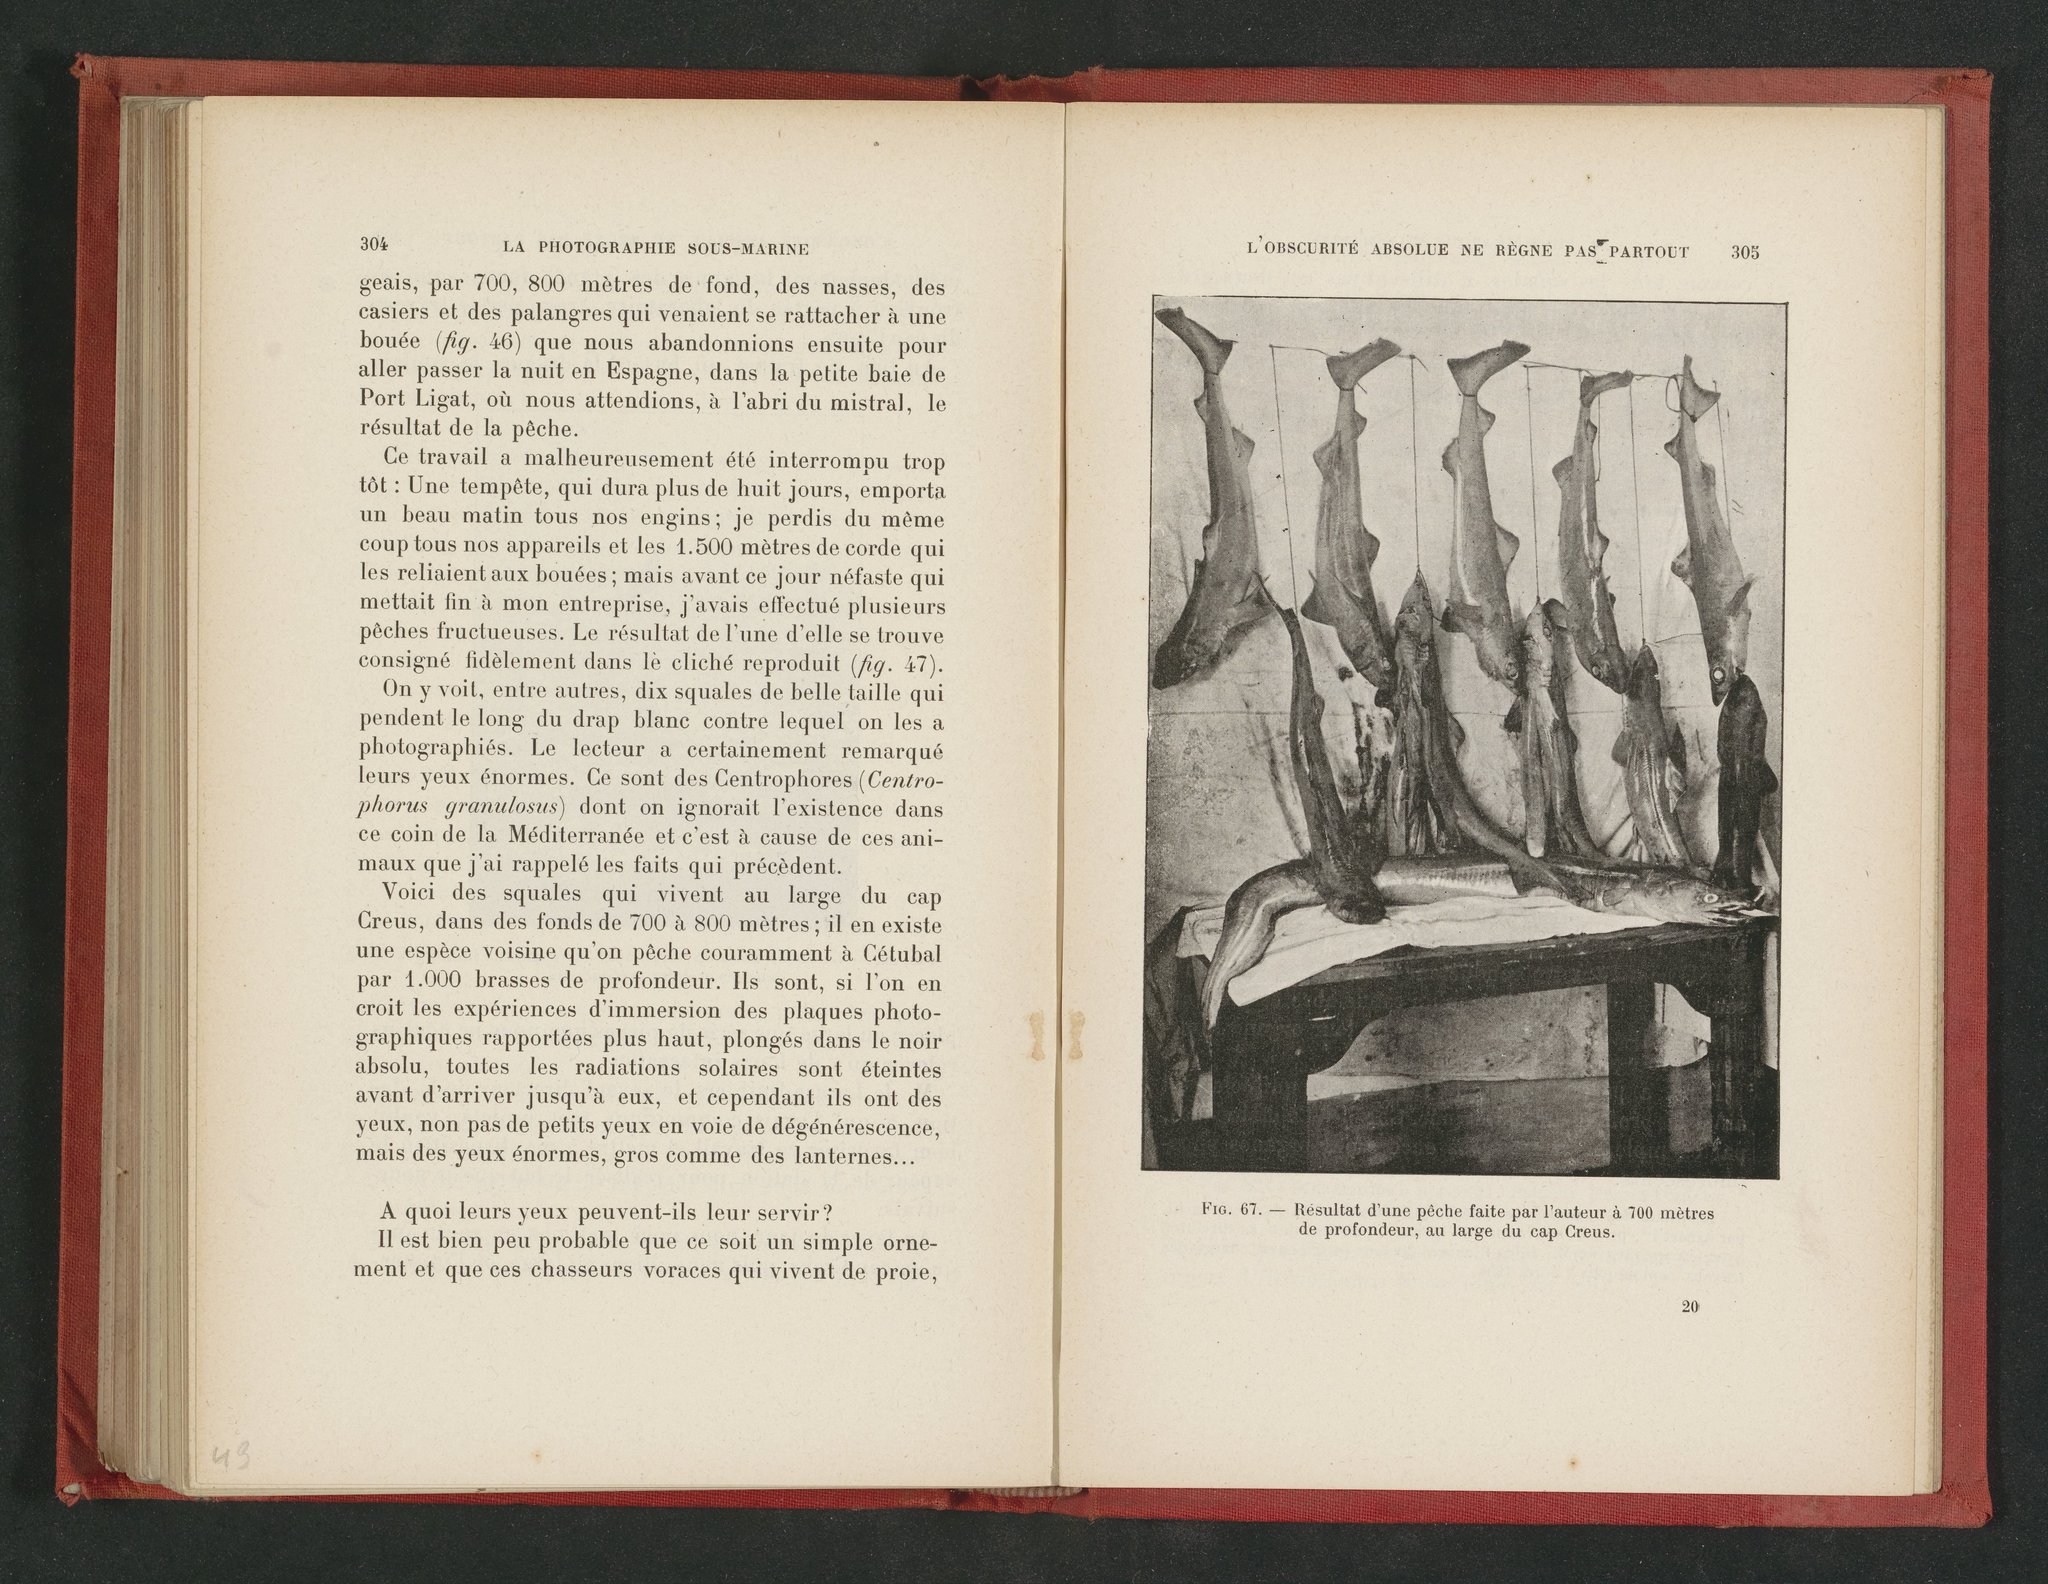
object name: photomechanical print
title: Vangst van haaien en vissen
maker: Anonymous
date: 1890-1900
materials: paper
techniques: autotype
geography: france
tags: fishes, fisherman showing catch, cartilaginous fishes: shark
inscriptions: number: ‘Fig. 67.’